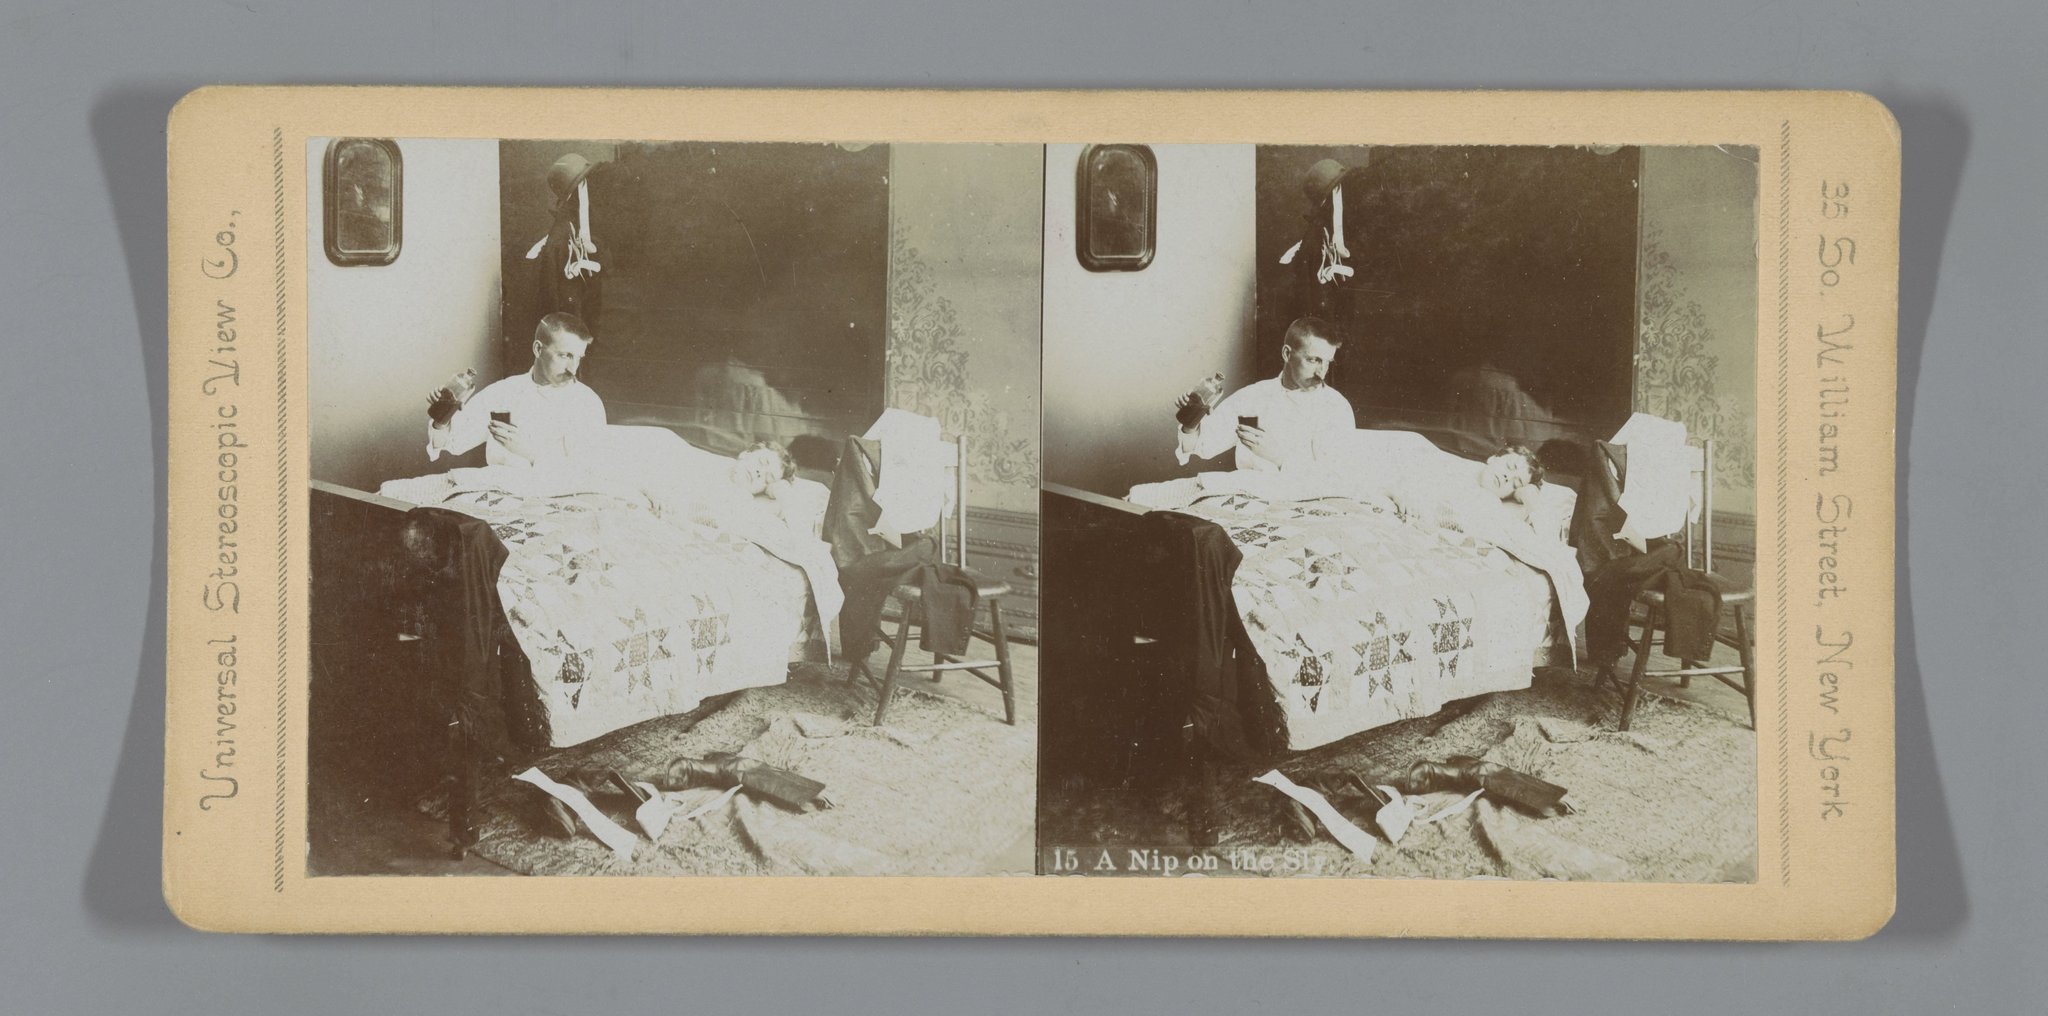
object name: stereograph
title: Echtpaar in bed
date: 1890-1910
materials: cardboard, photographic support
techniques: gelatin silver print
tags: bed, couple of lovers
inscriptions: number: ‘30’, address: ‘35 So. William Street, New York’, number: ‘15’